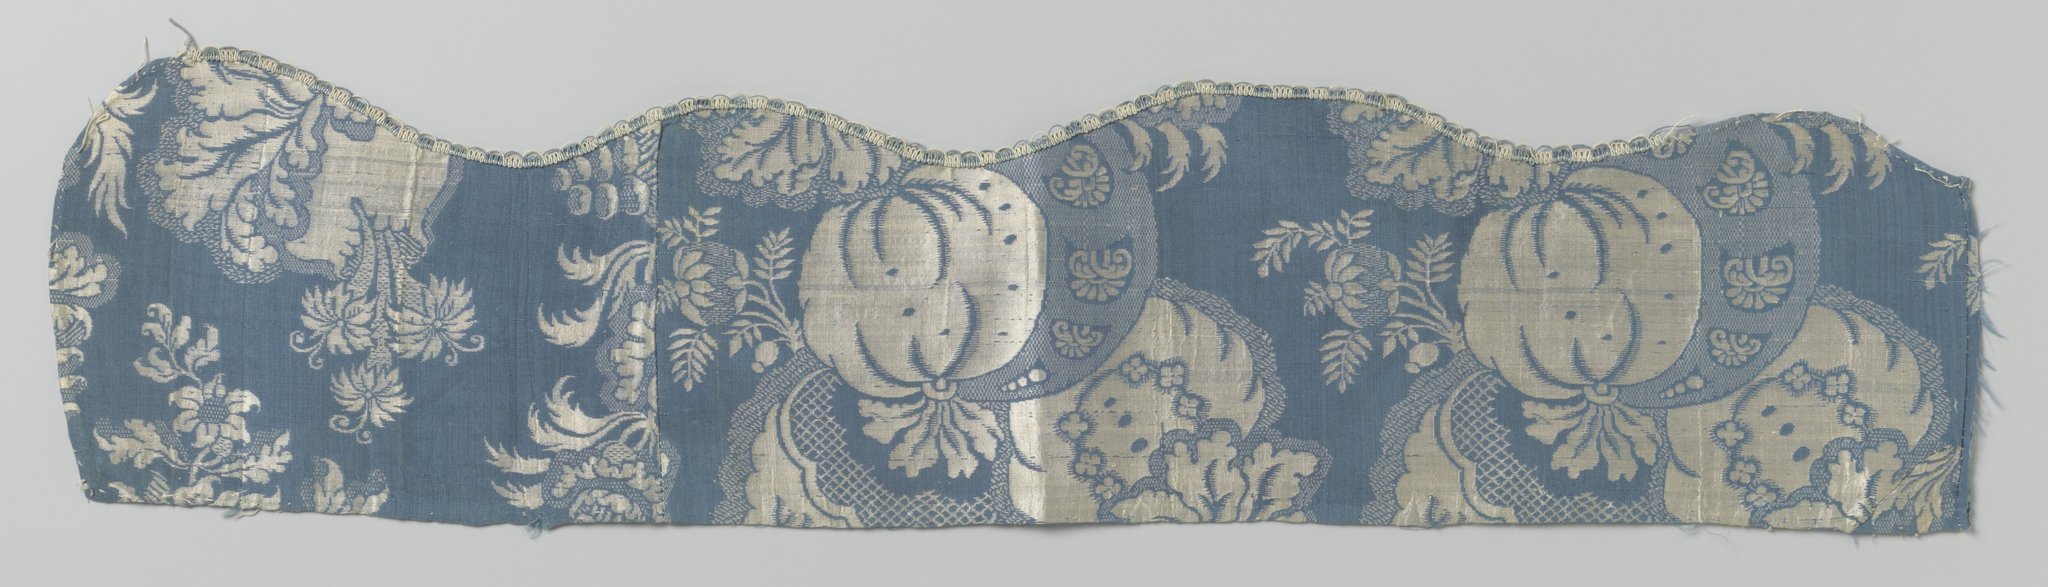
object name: silk textile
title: Fragment van een zijdeweefsel met een patroon van een fors boeket en granaatappel in wit op blauw, een zogenaamd mozaïekdecor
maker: Anonymous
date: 1700-1725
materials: silk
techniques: weave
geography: france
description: Fragment van een zijdeweefsel met een lopend patroon van zeer grote bloemen en een vrucht. Een boeket is om een hangende granaatappel gerangschikt. Linksonder een peervormig blad met gelobde contouren en mozaïekranden en nerf. Rechtsonder een losse bloem, linksboven een papaver met grote zaadbol als hart en rechtsboven drie uitschuivende bloemen. Onder het blad een gebogen bloemtak op een schuin afgesneden verbrede voet. Opmerking: fragment bekleding (?) van een "wangenstoel".